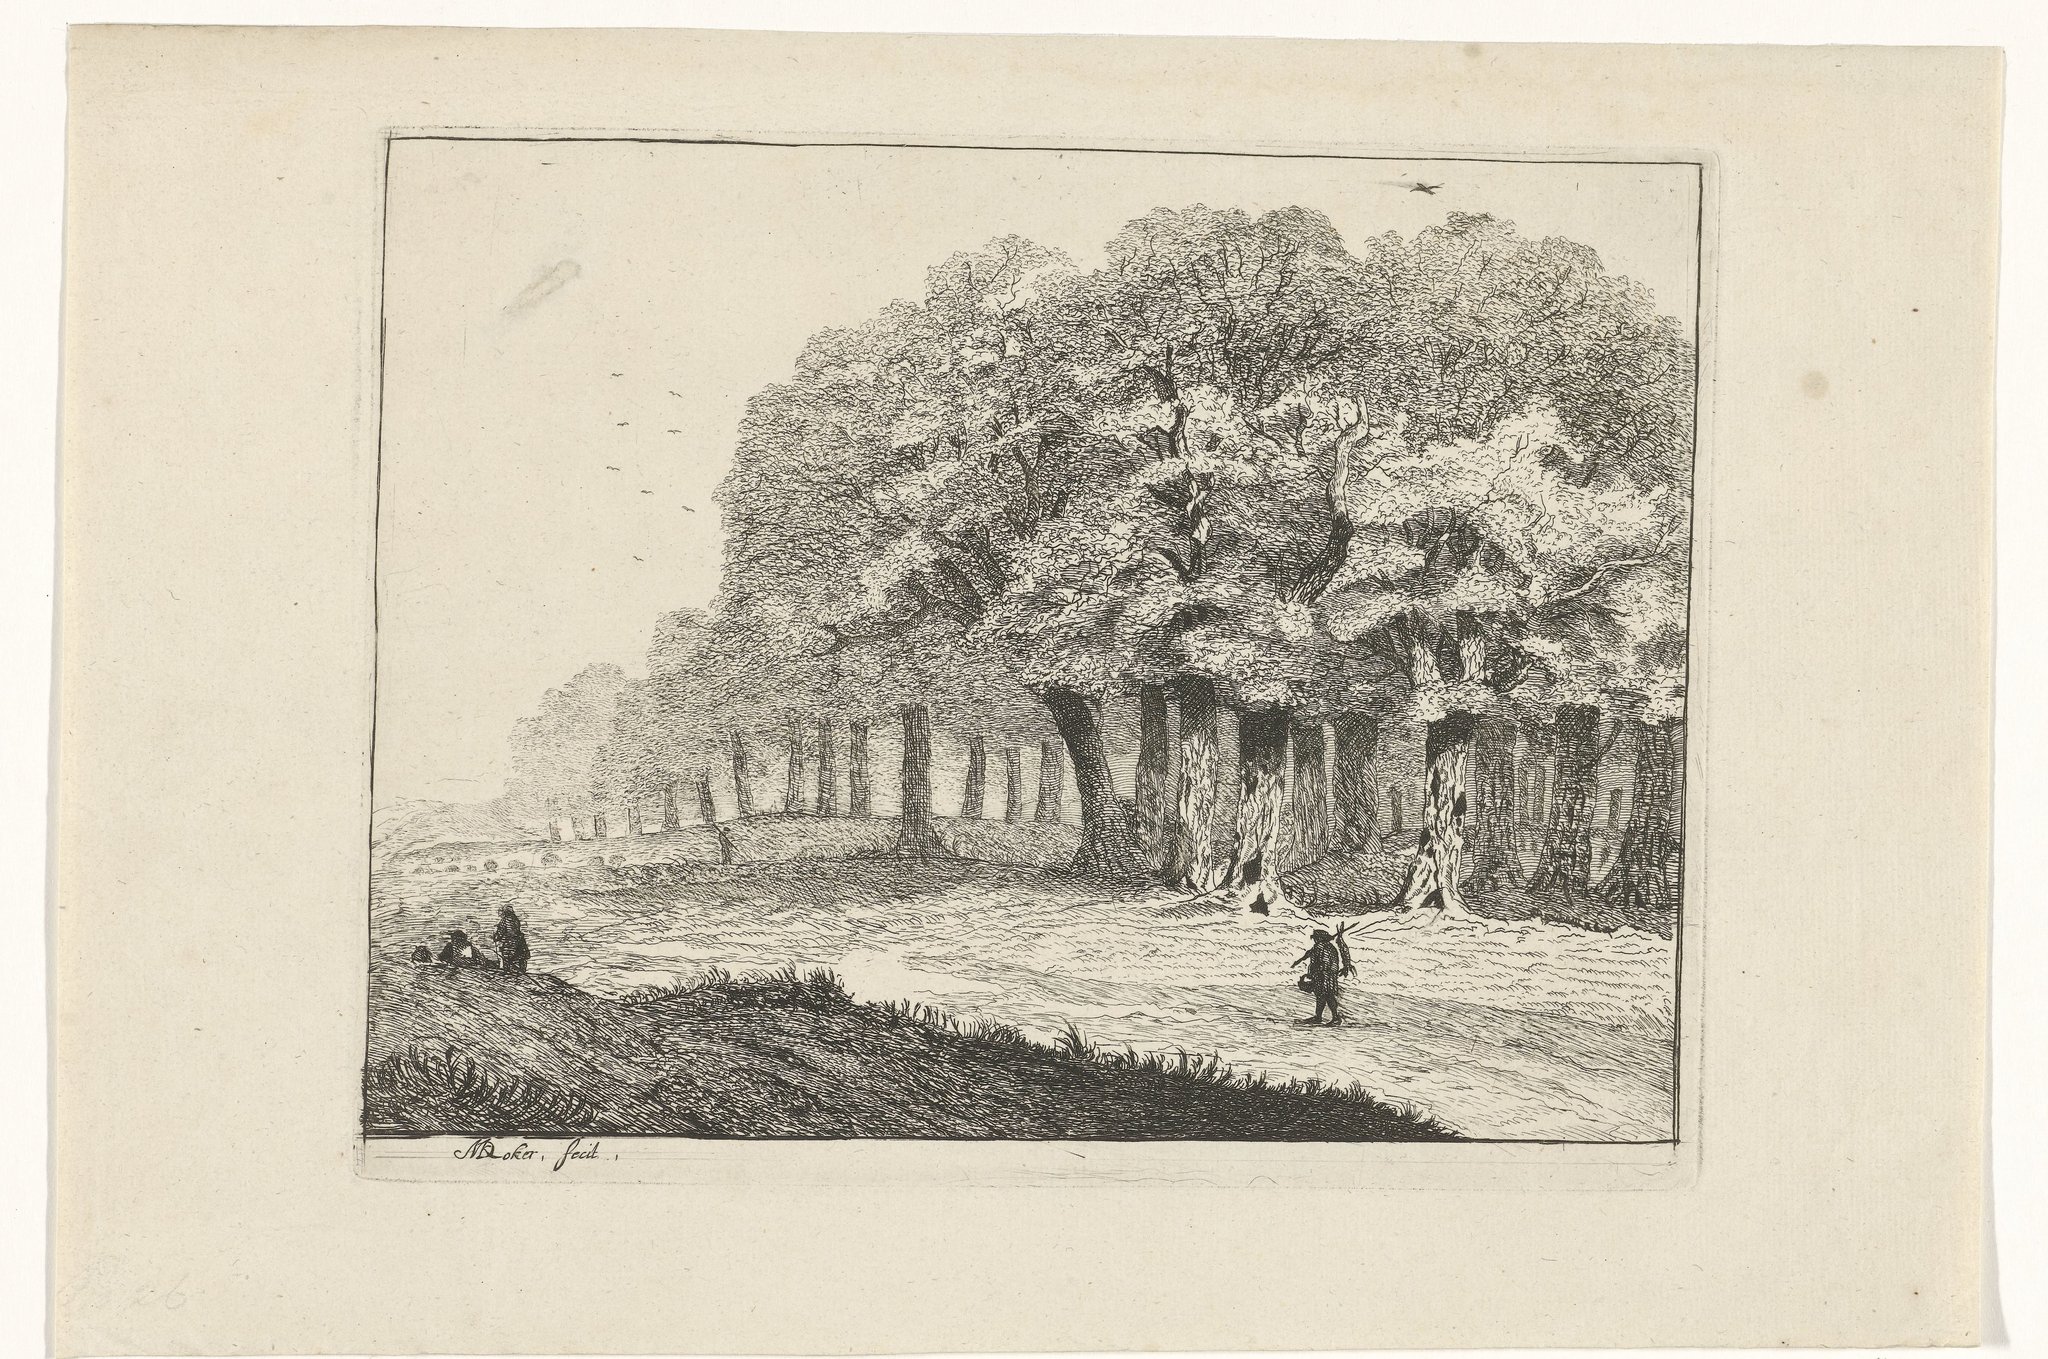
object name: print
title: Gezicht op de rand van een bos met een terugkerende jager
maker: anna maria de koker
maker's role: print maker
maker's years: -1698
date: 1640-1698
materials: paper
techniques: etching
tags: herding, herdsman, herdswoman, shepherd, shepherdess, cowherd, etc., road, path, forest, wood, return from the hunt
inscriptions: collector's mark: Lugt 2228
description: Langs de rand van een bos loopt een jager met over zijn schouder een stok waaraan een haas hangt. Links van het pad zit een drietal mensen en op de achtergrond is een herder met zijn schapen te zien. In de lucht vliegen enkele vogels.